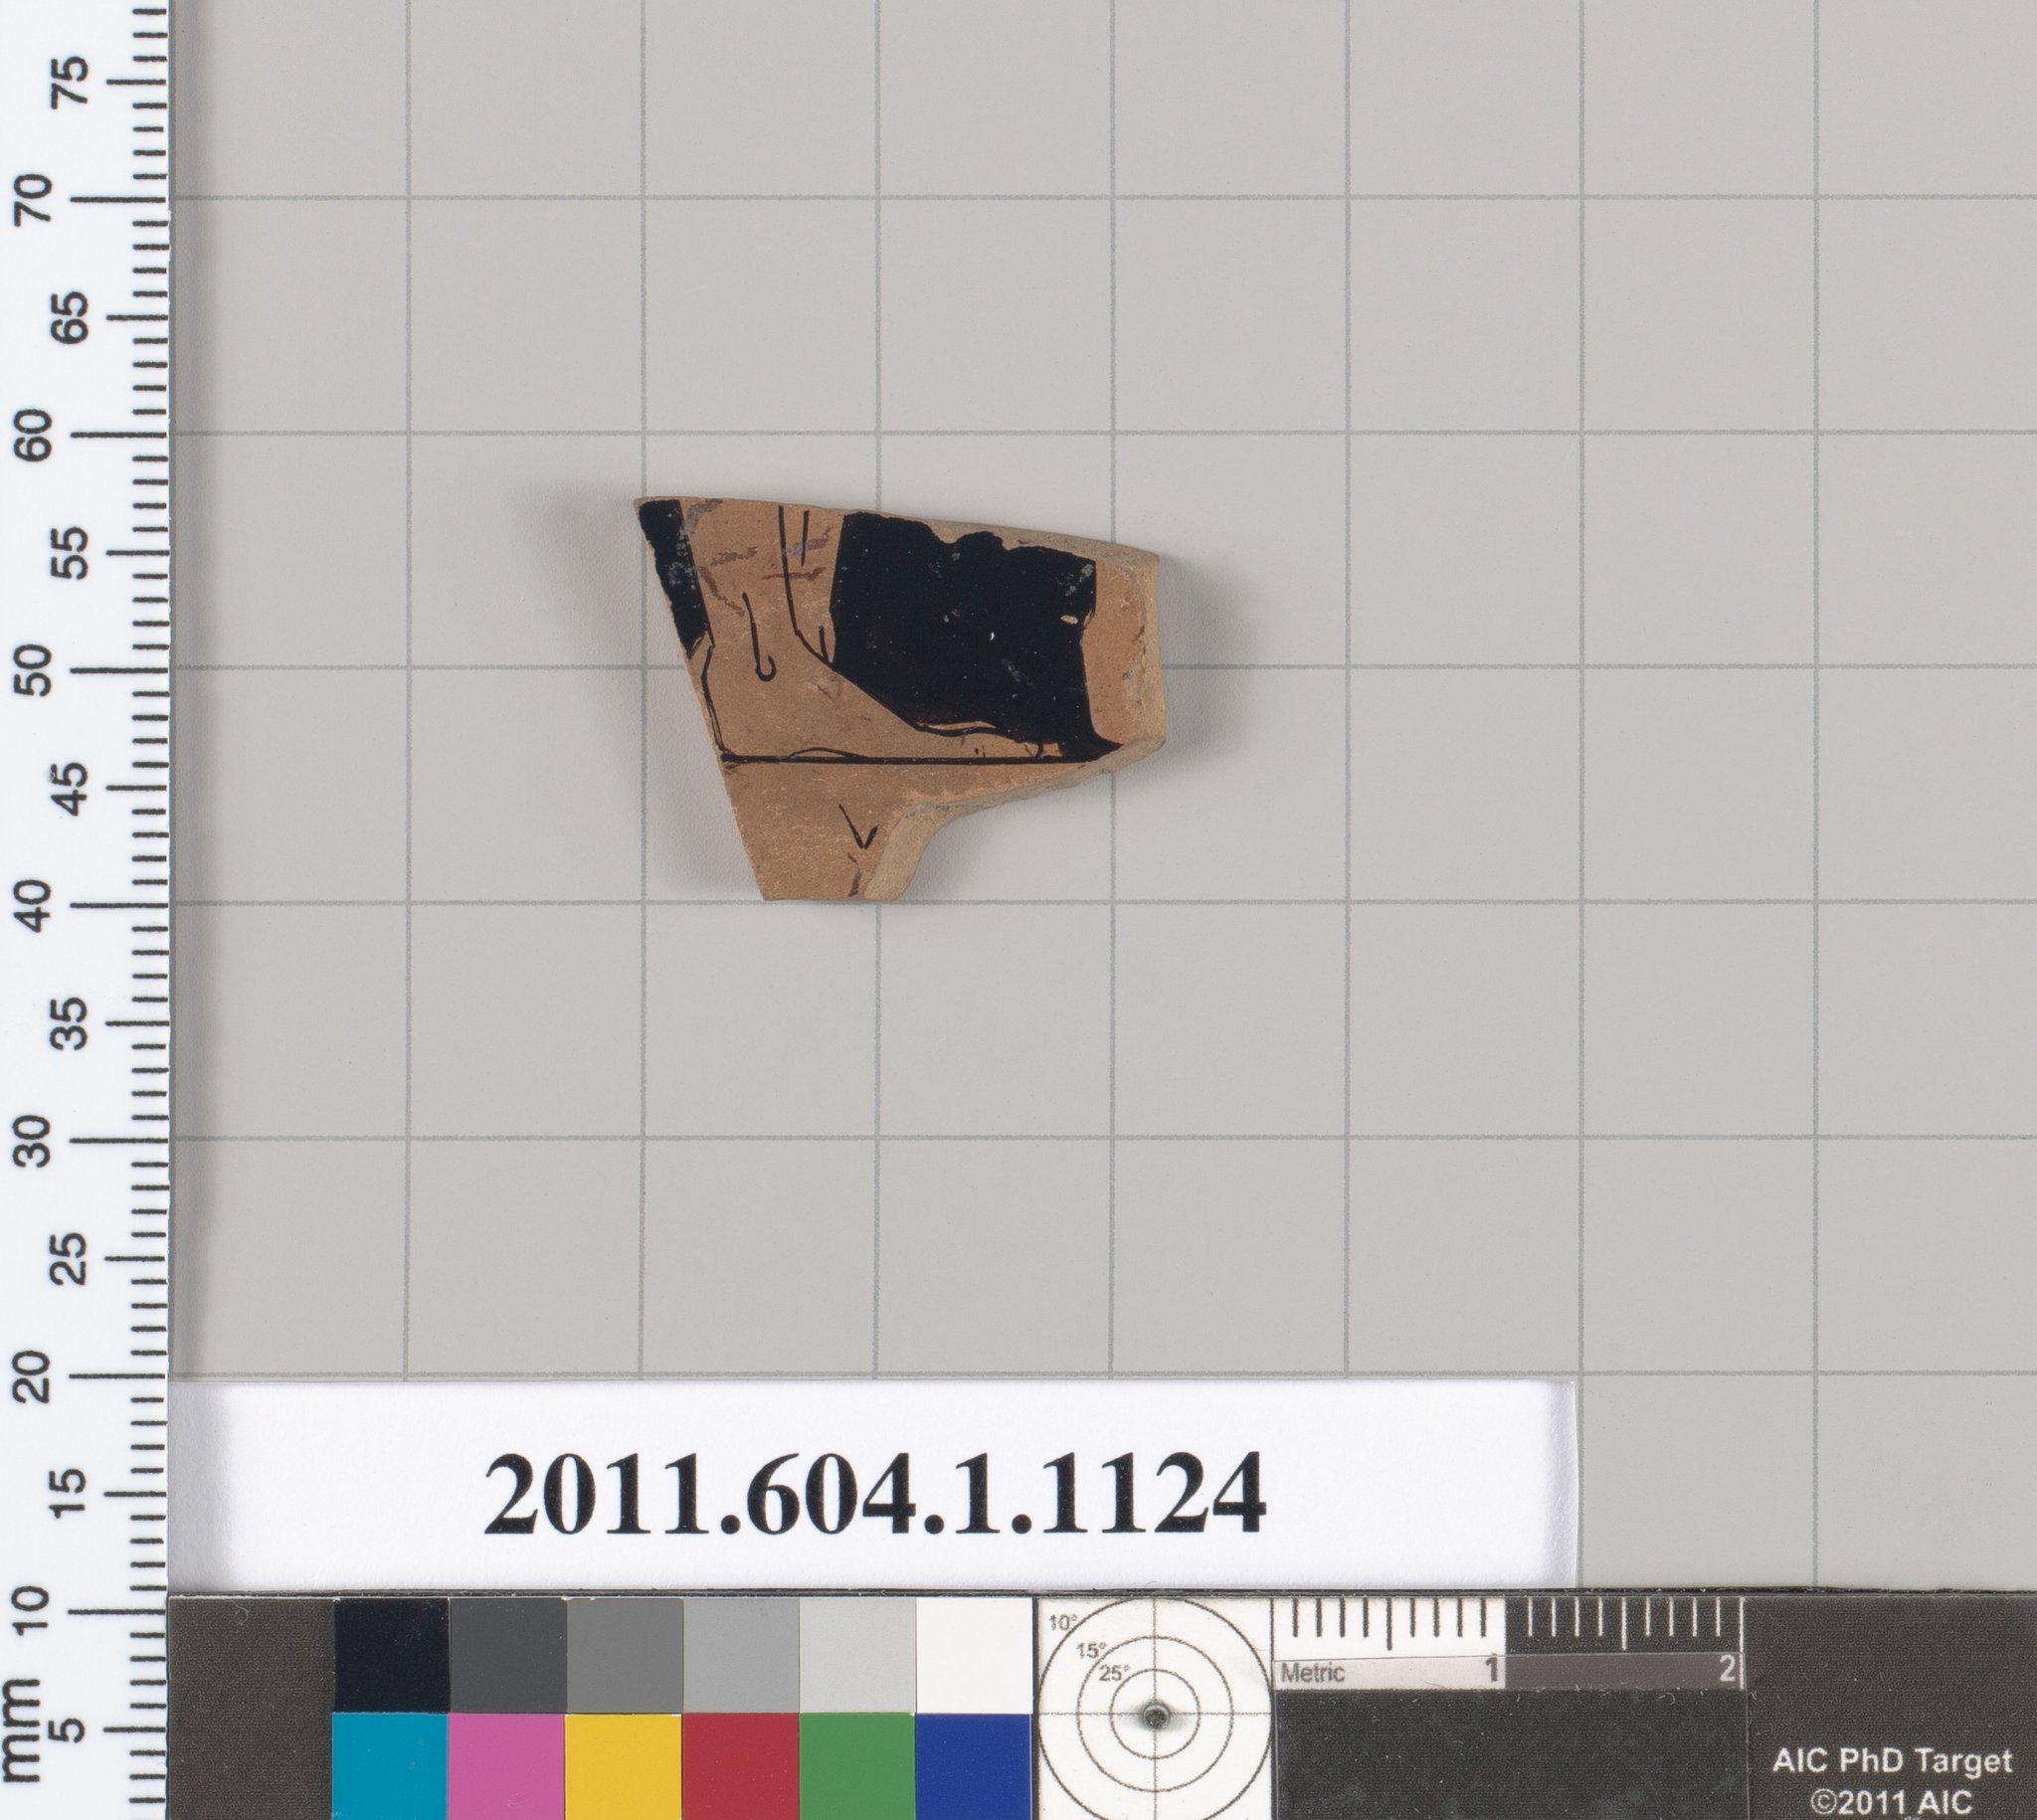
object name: kylix fragment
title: Terracotta fragment of a kylix (drinking cup)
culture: greek, attic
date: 475-451 BCE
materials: terracotta